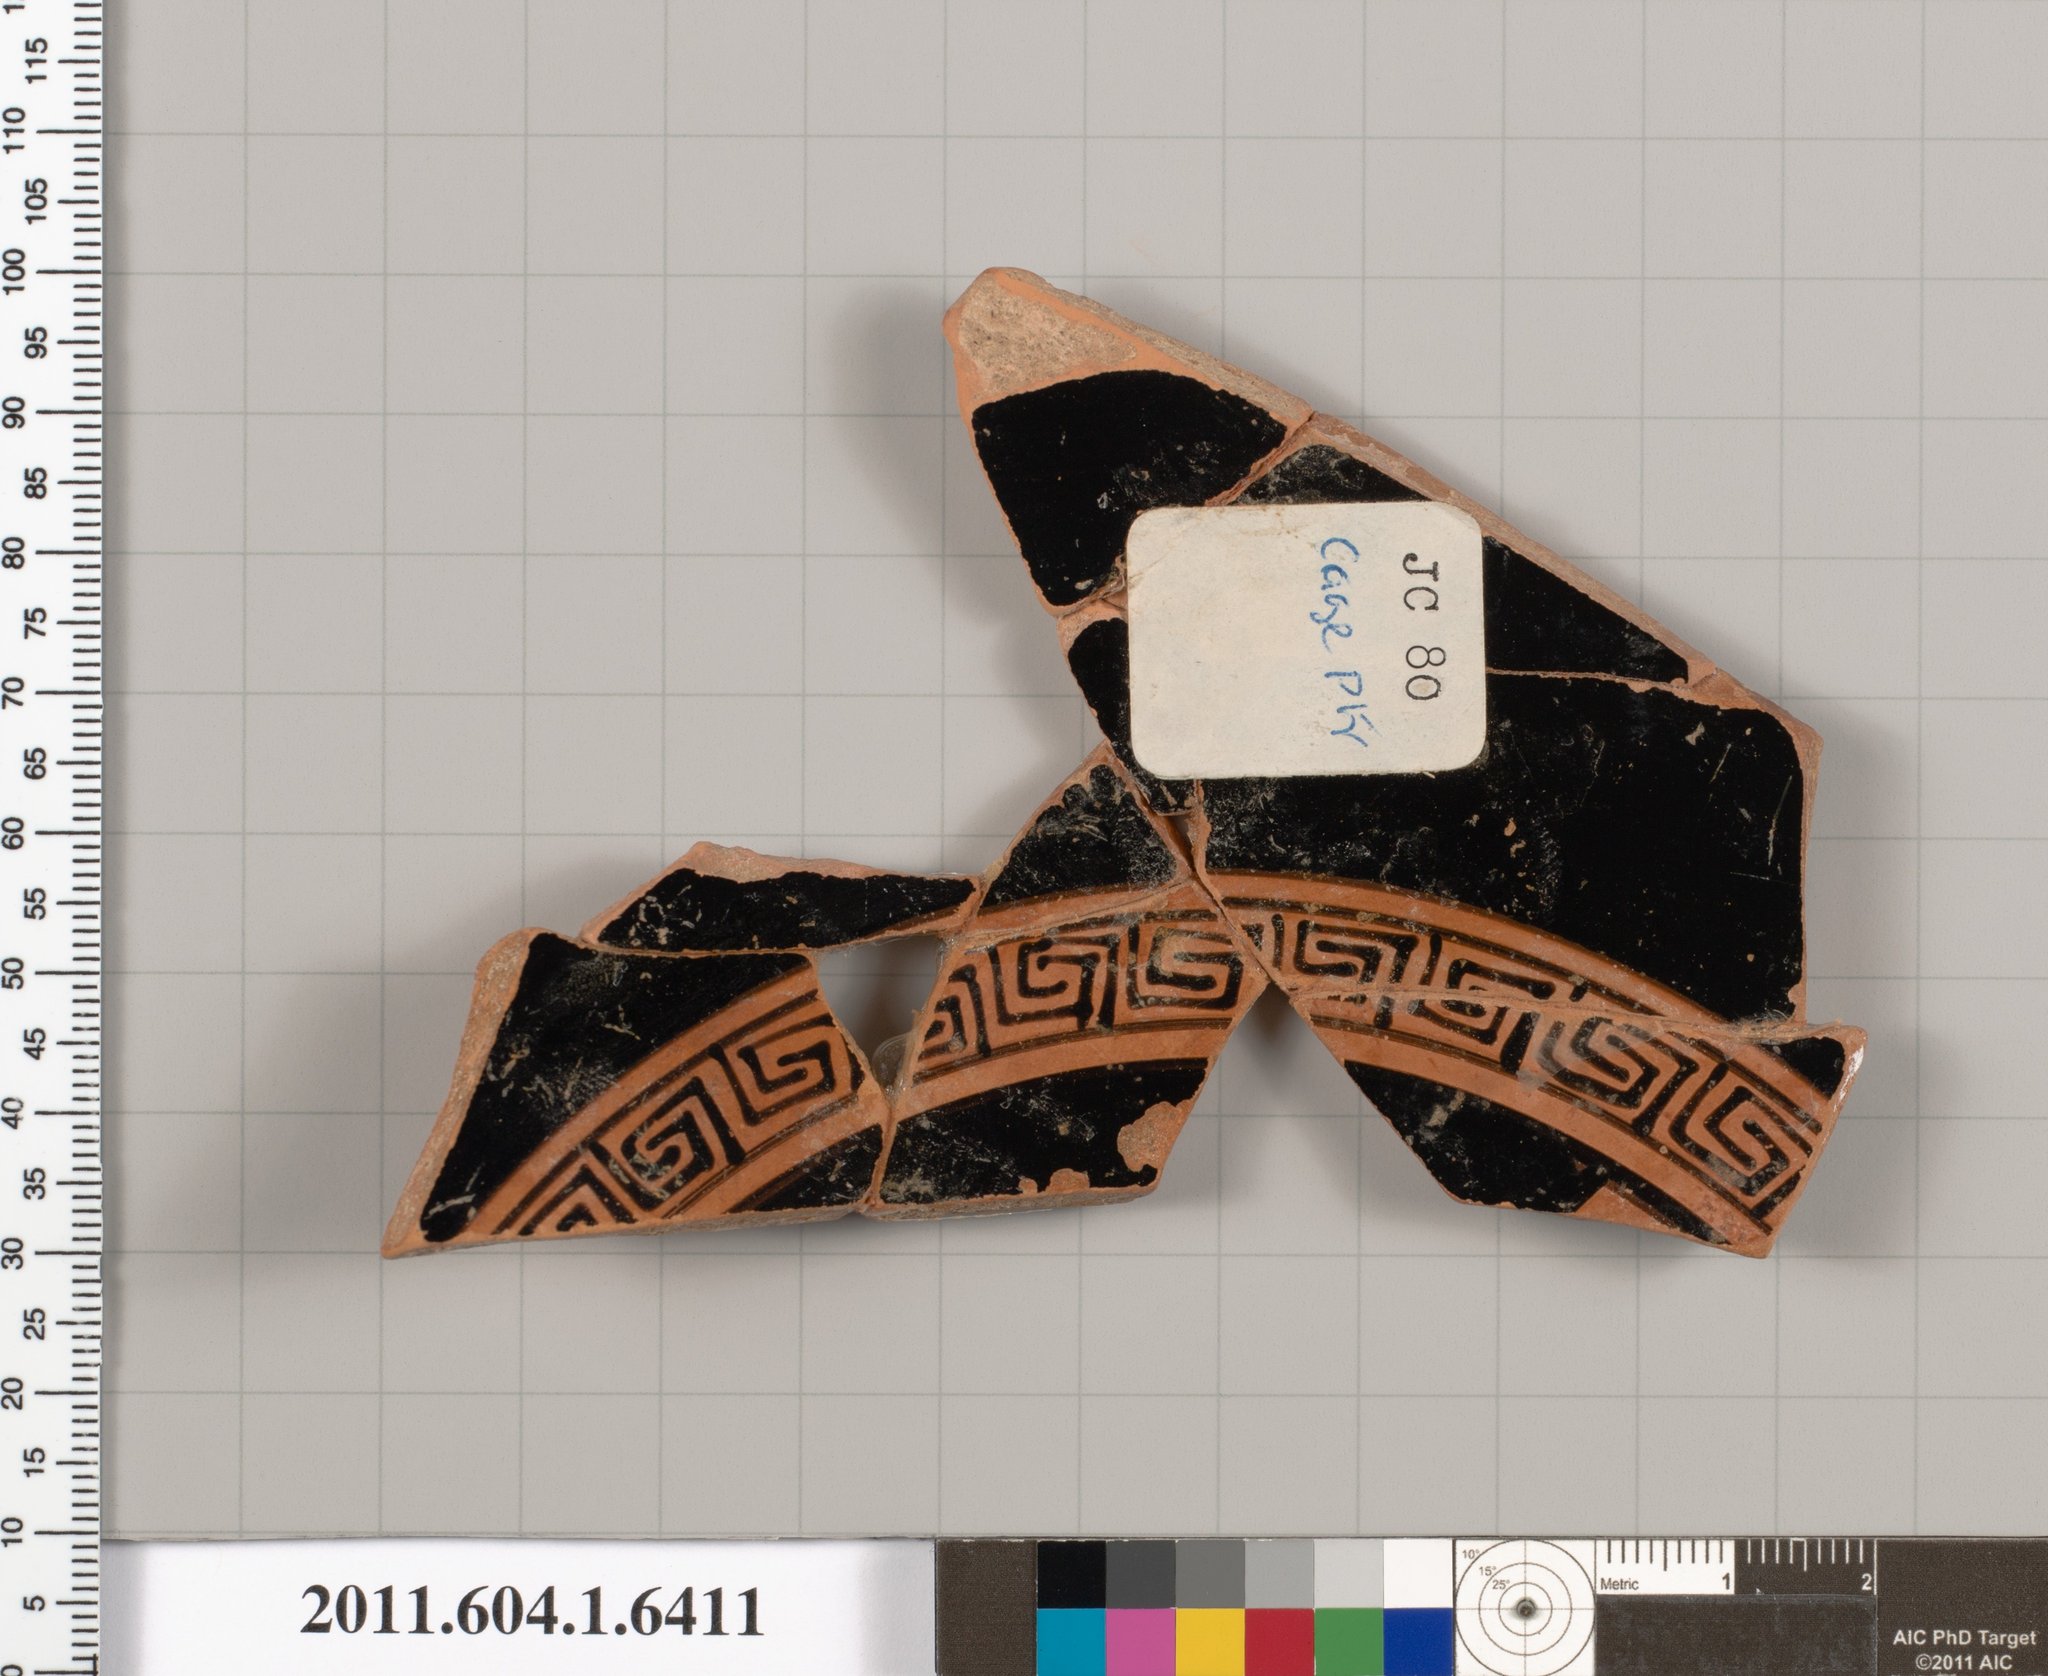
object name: kylix fragment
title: Terracotta fragment of a kylix (drinking cup)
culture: greek, attic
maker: cage painter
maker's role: artist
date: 490-480 BCE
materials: terracotta